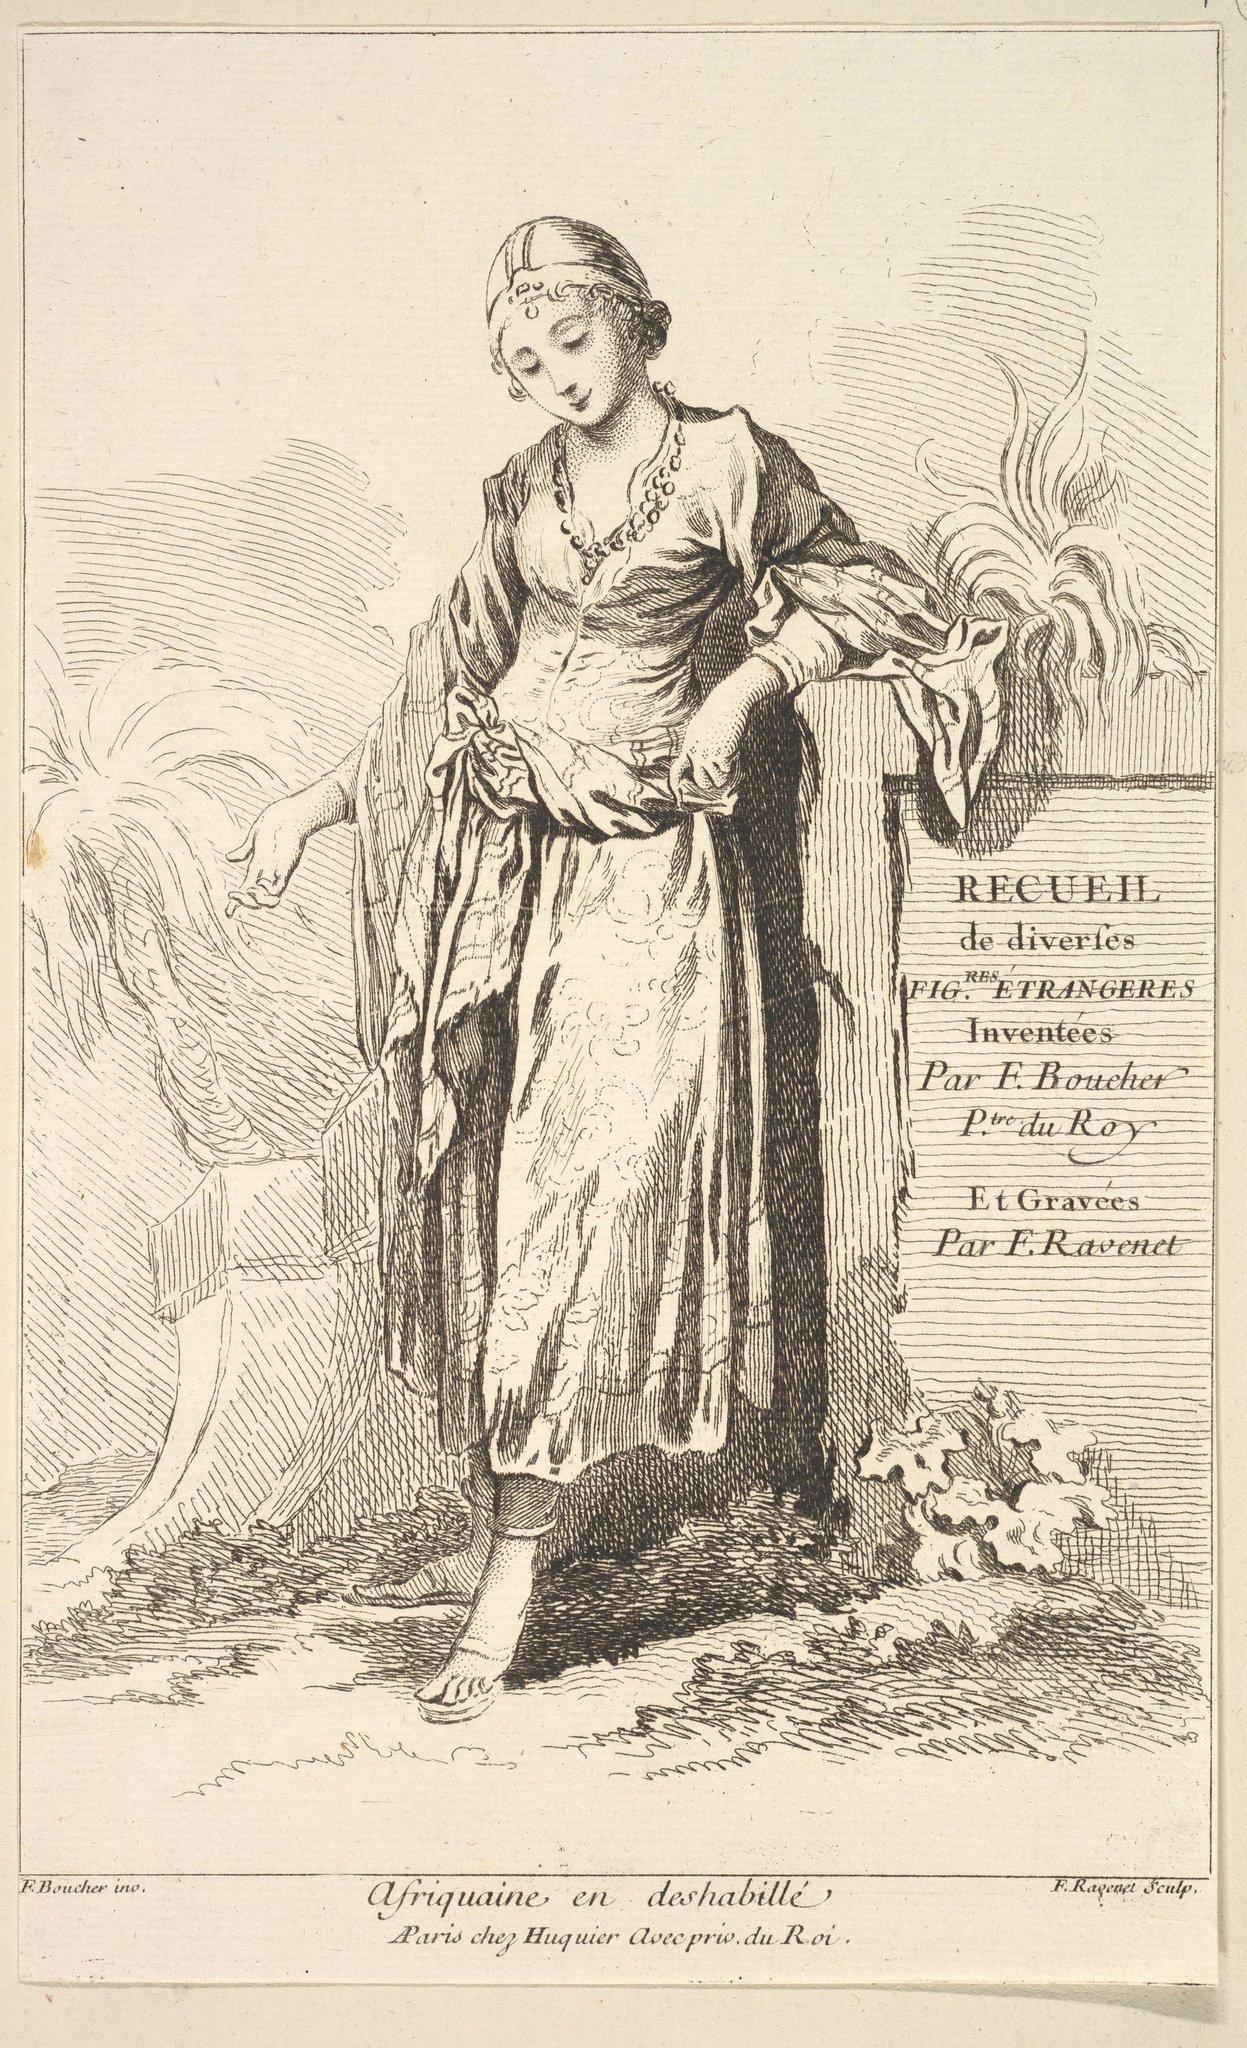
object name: print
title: Afriquaine en deshabillé, plate 1 from "Recueil de diverses fig.res étrangeres Inventées par F. Boucher P.tre du Roy et Gravées par F. Ravenet" (Collection of Various Foreign Figures, Devised by F. Boucher, Painter of the King and Engraved [etched] by F. Ravenet)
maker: simon francis ravenet, the elder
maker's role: artist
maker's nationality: french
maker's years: 1706-1774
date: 1701-1800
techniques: engraving, etching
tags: women